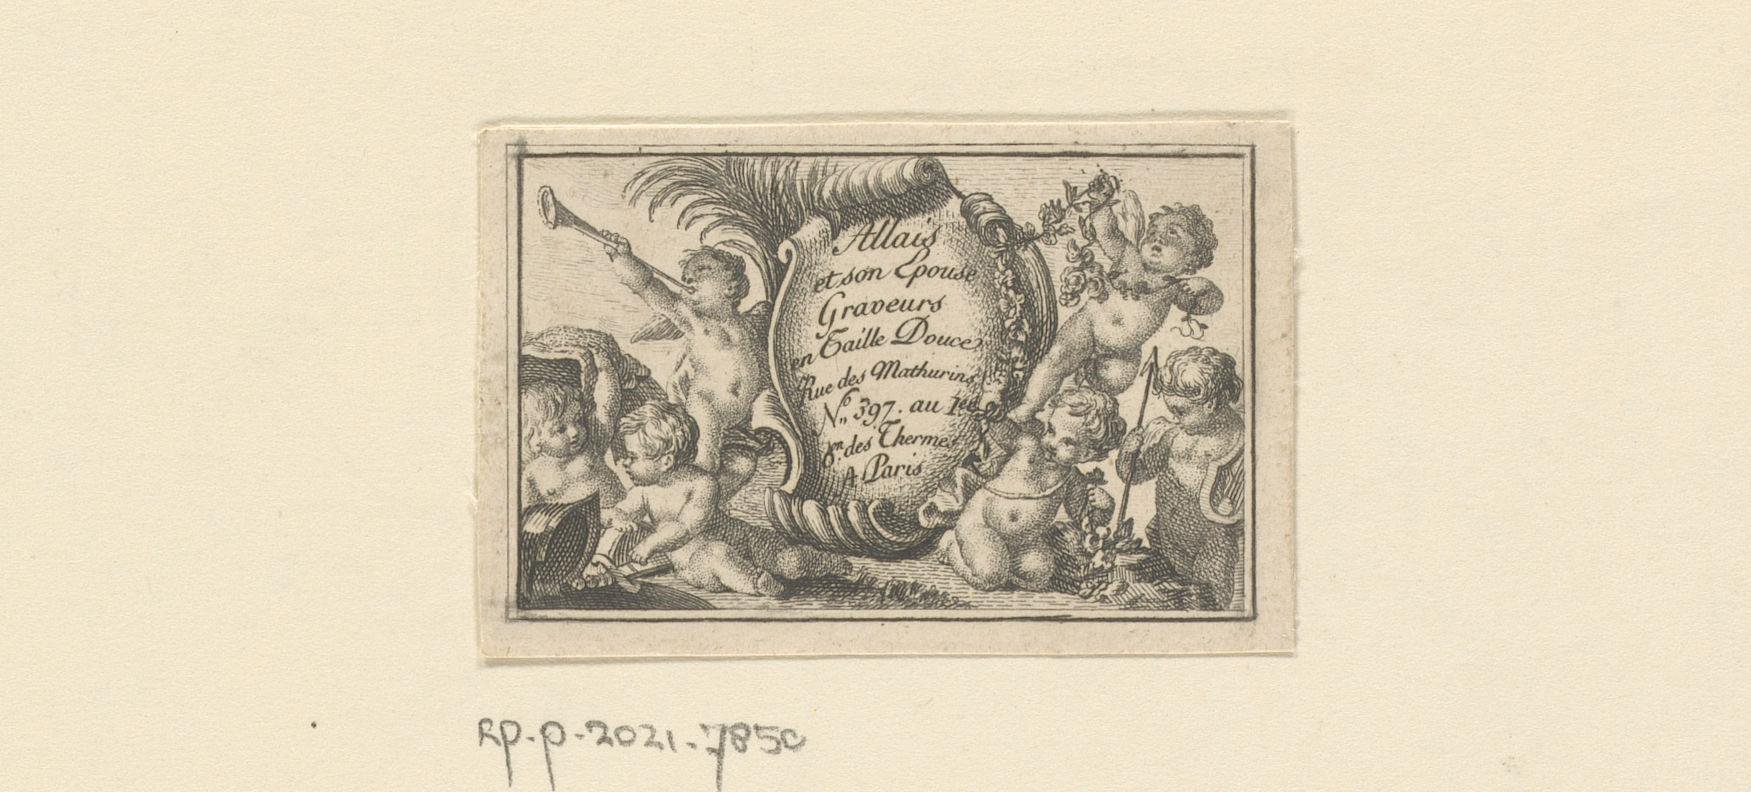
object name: visiting card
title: Visitekaart van Louis Jean Allais en Angélique Briceau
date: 1791-1827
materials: paper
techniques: etching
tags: print maker, louis jean allais, angélique briceau, visiting-card, calling-card, paris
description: Een groep putti met diverse attributen bij een schild met daarop: 'Allais et son Epouse Graveurs en Taille Douce. Rue des Mathurins No. 397 au [...] des Thermes a Paris'.